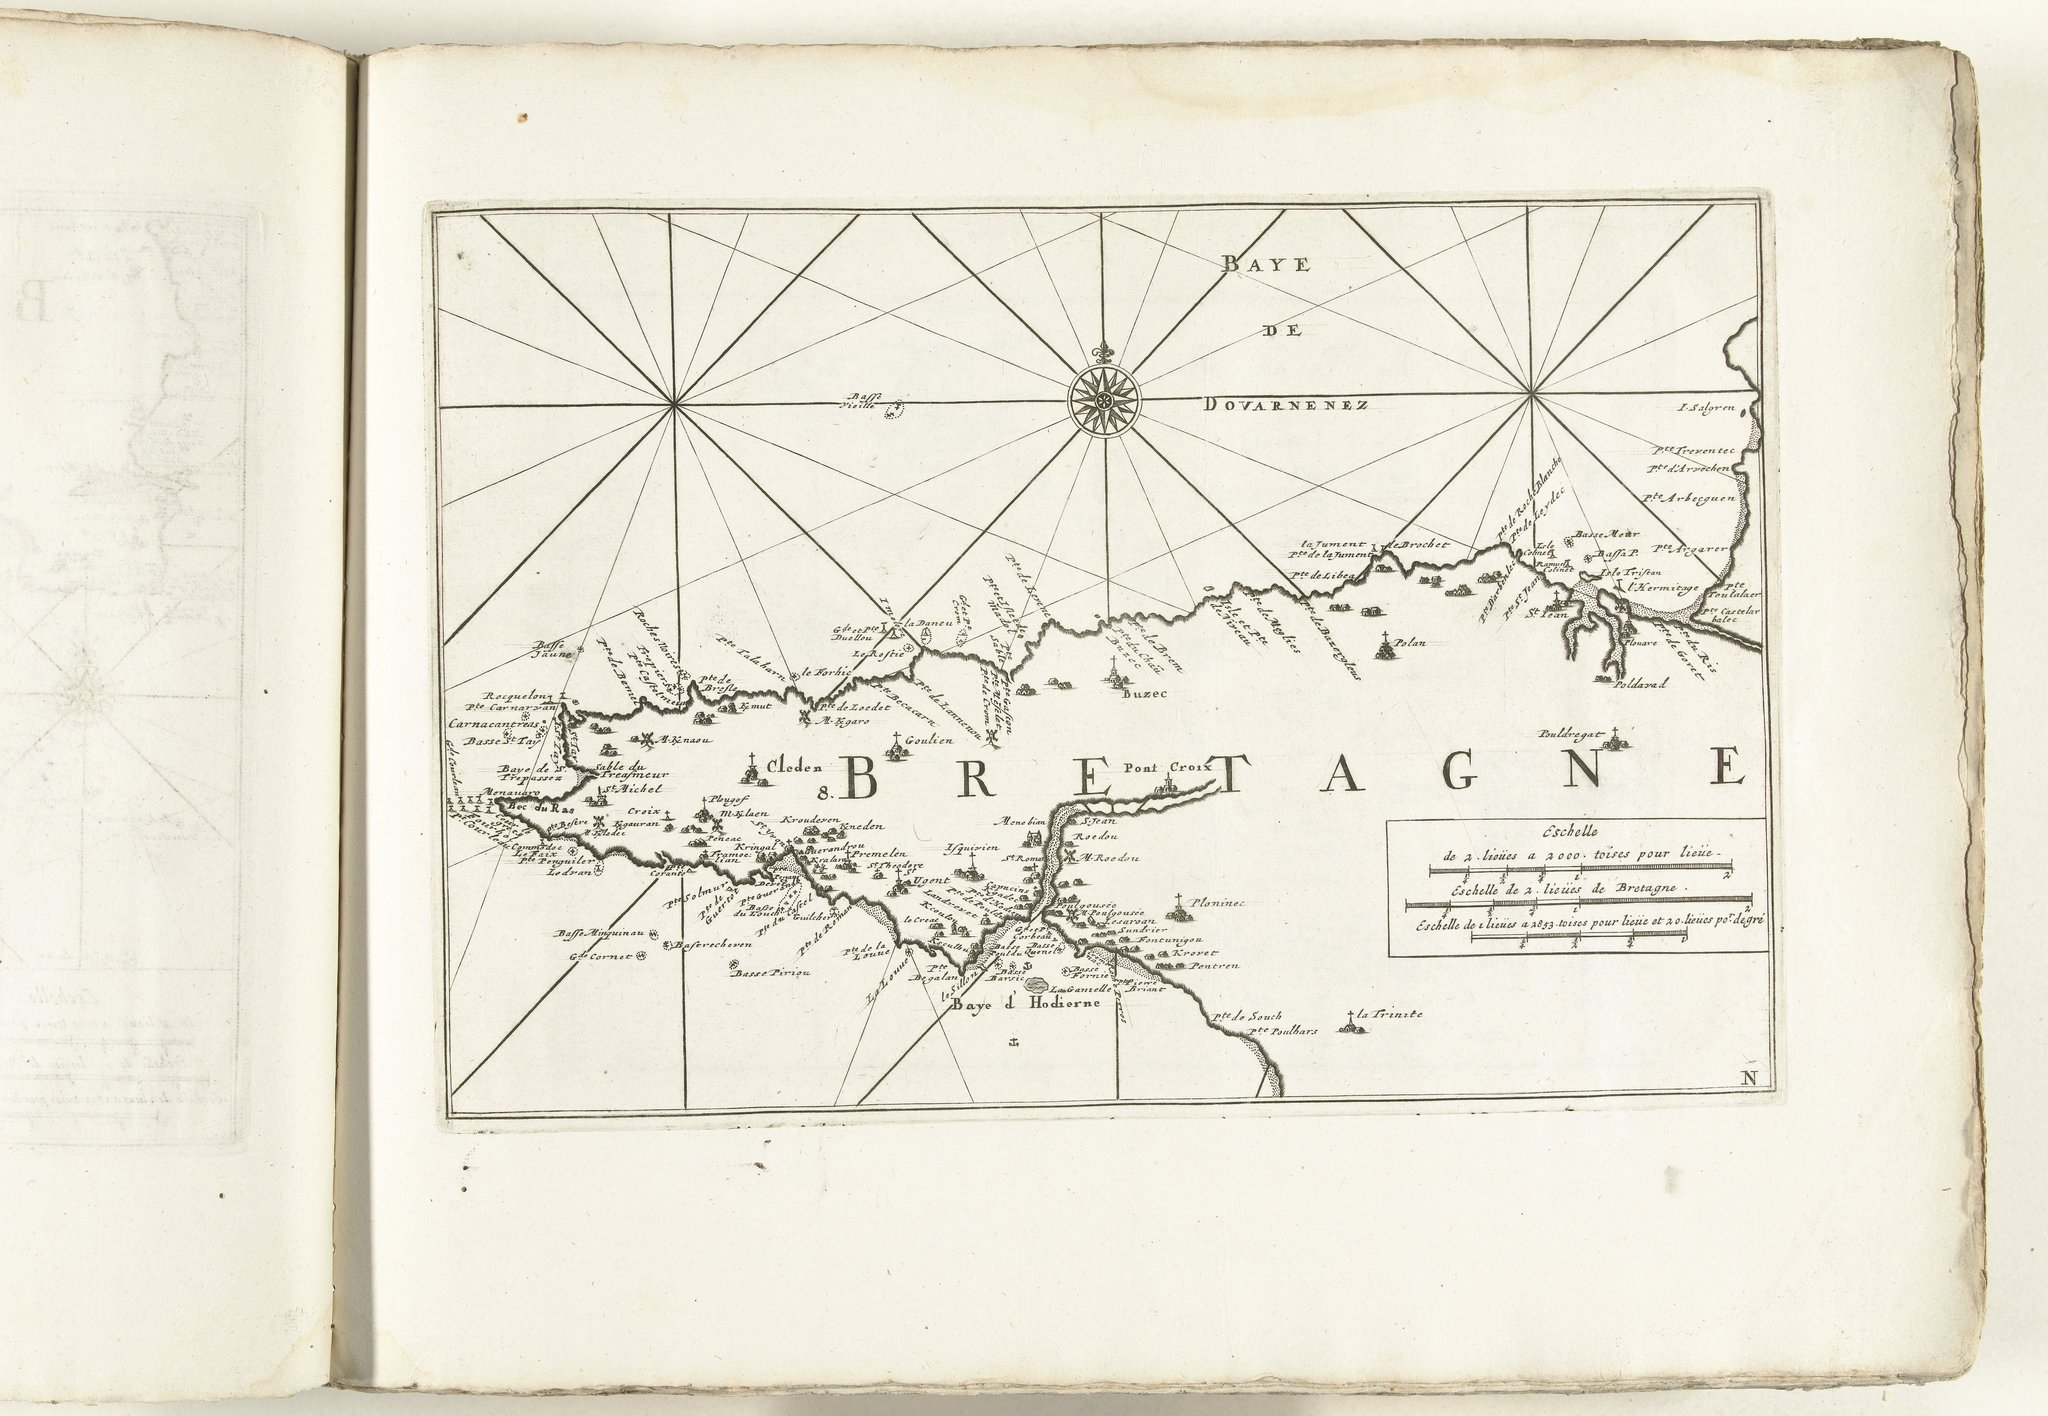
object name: map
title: Les Forces de l'Europe, Asie, Afrique et Amerique, ou description des principales villes avec leurs fortifications. Dessignées par les meilleurs ingenieurs, particulierement celles qui sont sous la domination de la France (...) et ornées de plusieurs superbes edifices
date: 1702-1703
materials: paper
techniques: engraving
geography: northern netherlands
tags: maps of separate countries or regions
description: Kaart van de westkust van Bretagne. Gemerkt rechtsonder: N. Onderdeel van het eerste van twee delen van het prentwerk: Les costes de France et d'Espagne (oftewel deel 13 van: Les Forces de l'Europe, Asie, Afrique et Amerique), uitgegeven ca. 1702. Het prentwerk bestaat in totaal uit 43 gemerkte platen van de kust van Frankrijk en Spanje, in het kader van de Spaanse Successieoorlog. Deze platen zijn gekopieerd naar anonieme Franse platen oorspronkelijk uitgegeven door Nicolas de Fer te Parijs. Titel en opschriften in de plaat in het Frans.